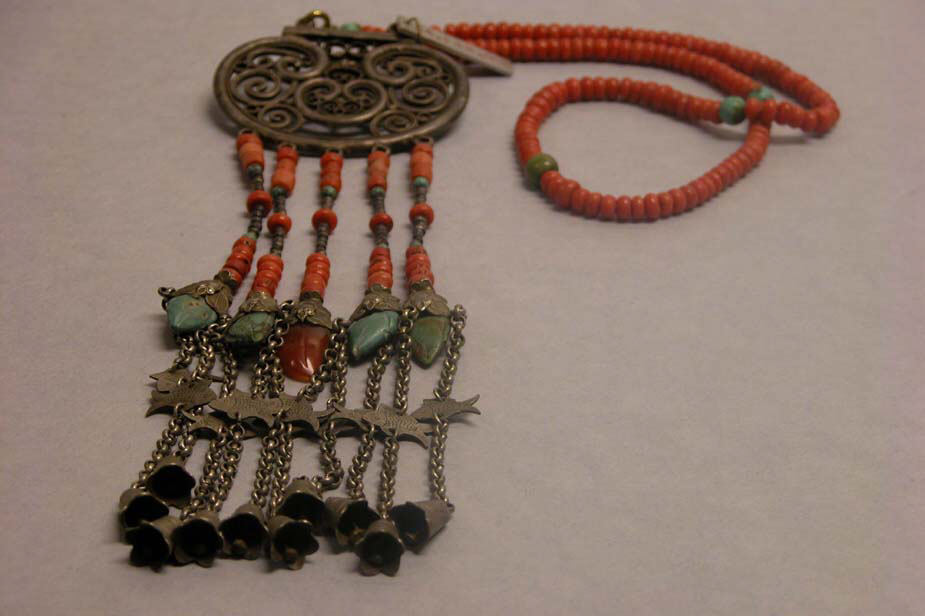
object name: ornament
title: Man's hair ornament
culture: tibetan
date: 1801-1900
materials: jade, silver